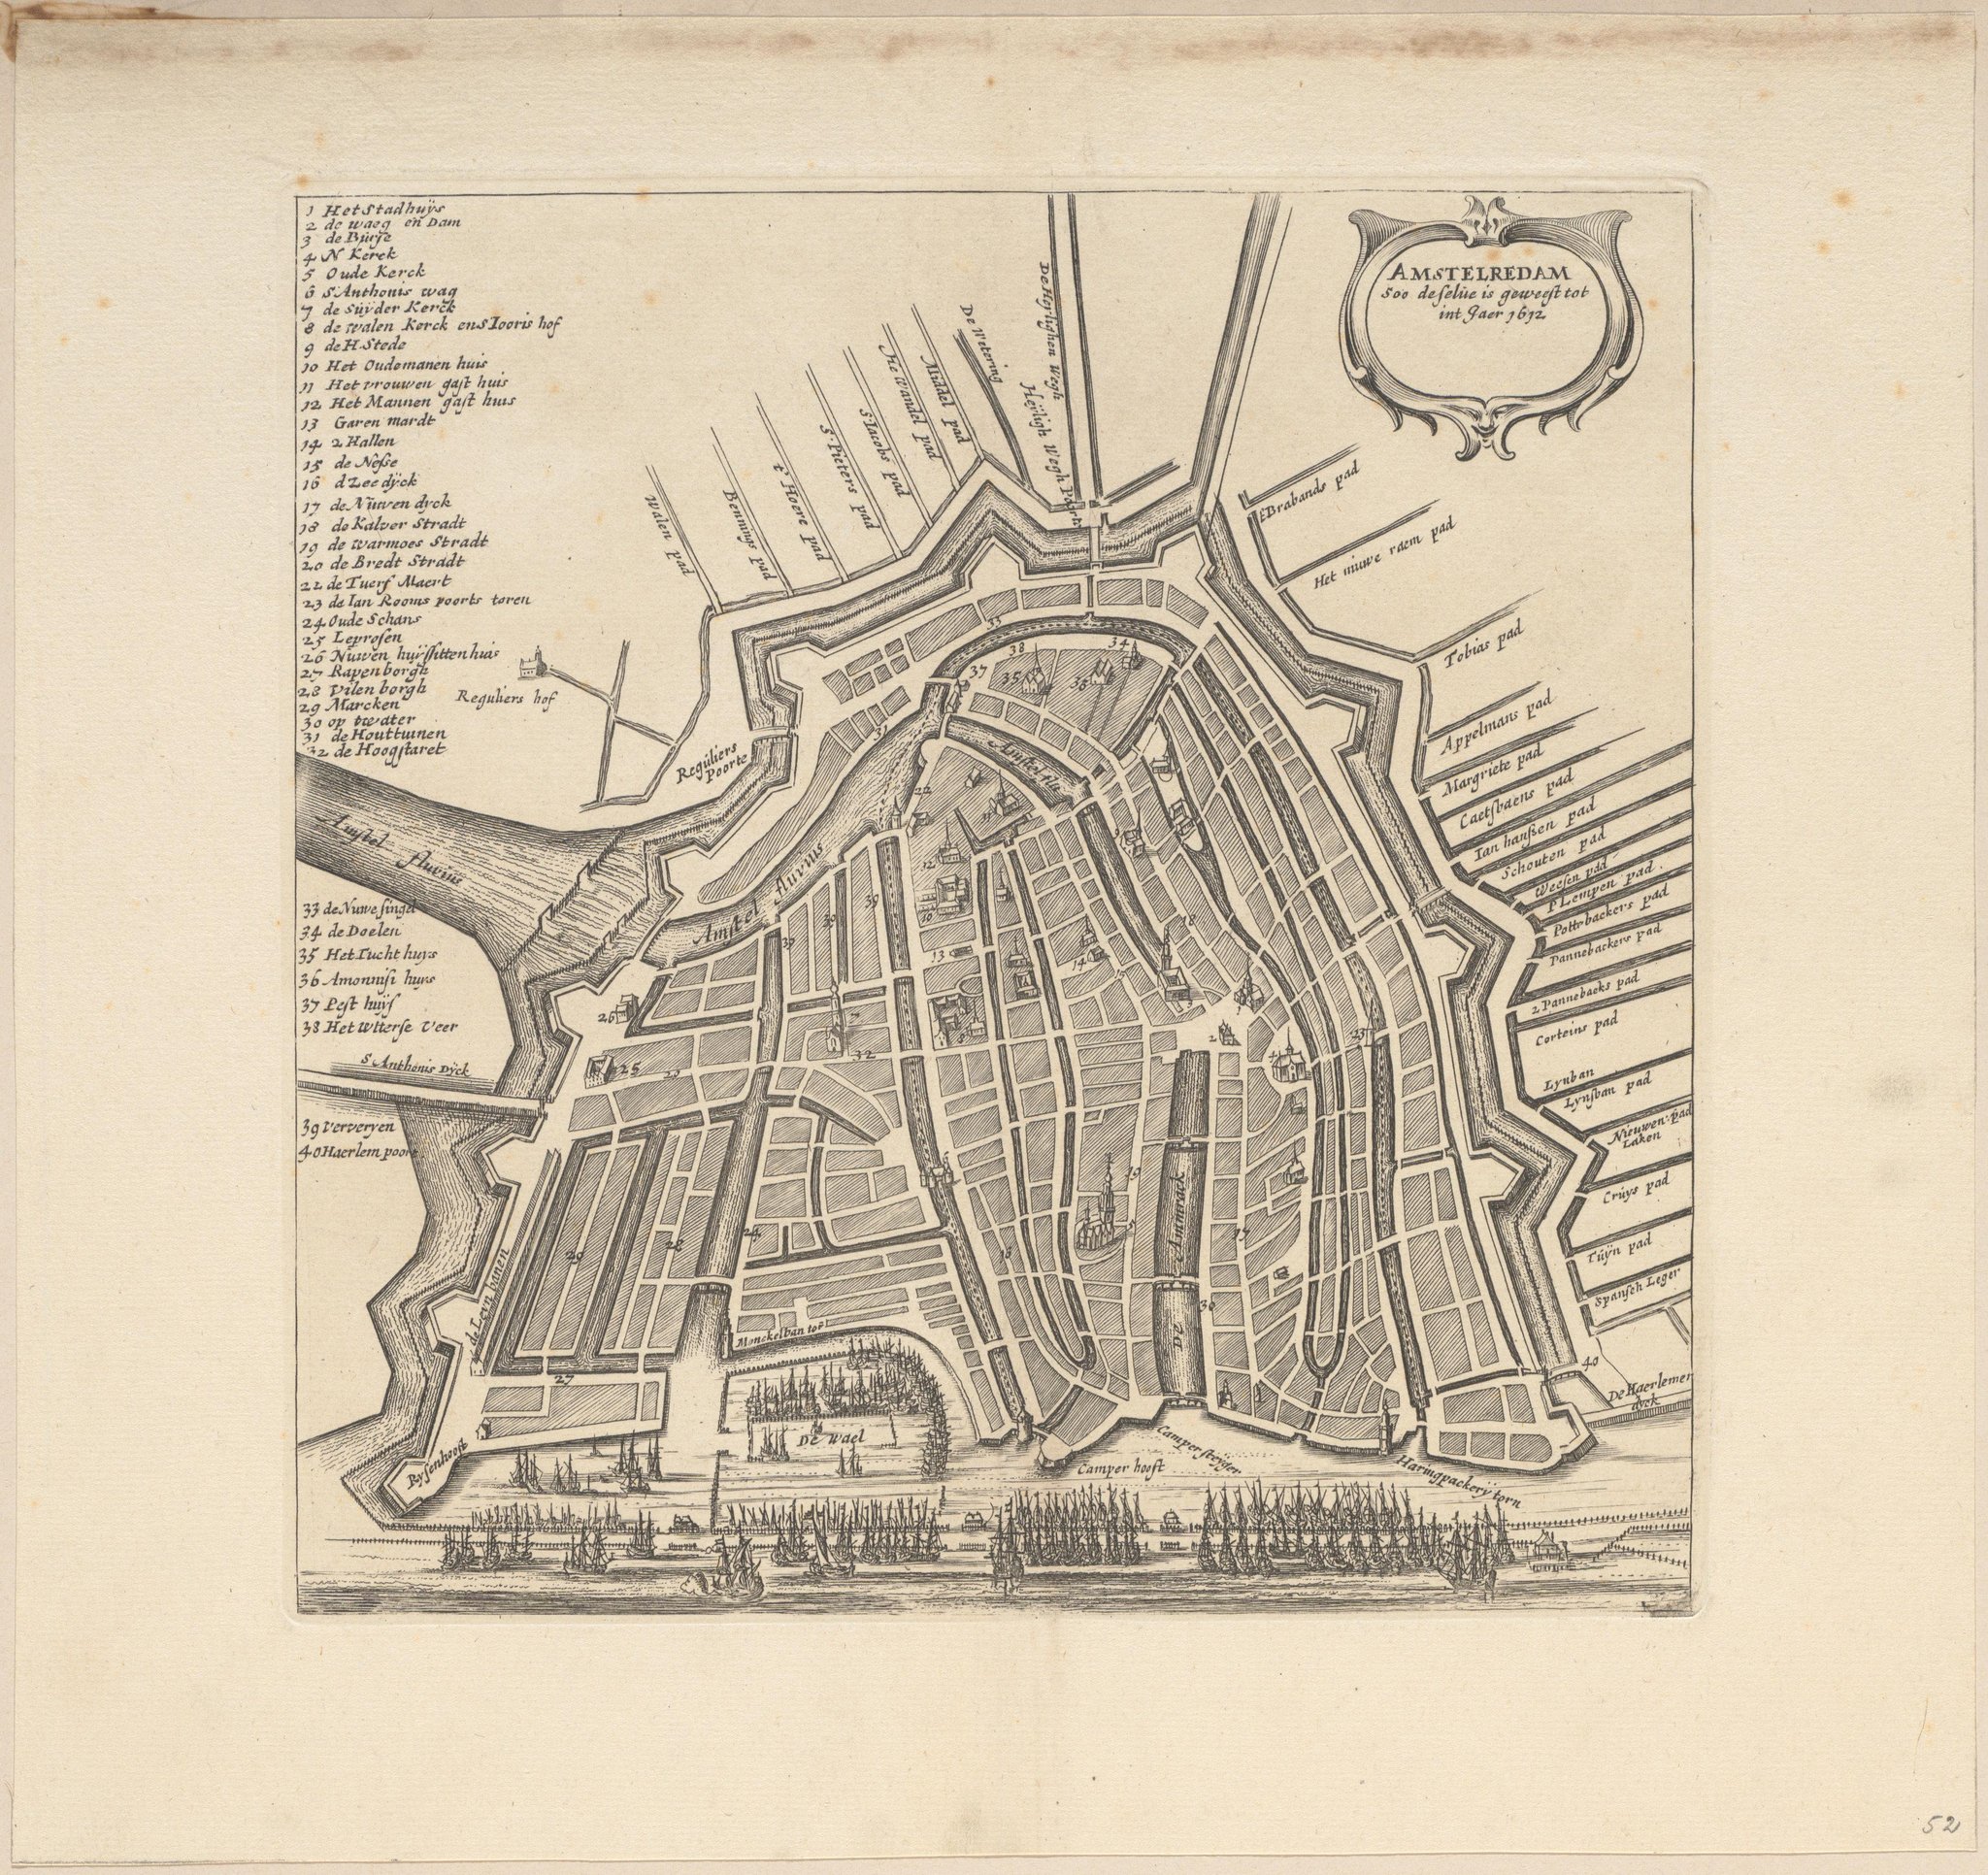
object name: map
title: Amstelredam Soo deselve is geweest tot int Jaer 1612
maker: Anonymous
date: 1663-1748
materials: paper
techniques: engraving, etching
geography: northern netherlands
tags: maps of cities, amsterdam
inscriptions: collector's mark: Lugt 1641b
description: Prent gebruikt in: Handvesten, privilegien, octroyen, costumen en willekeuren der stad Amstelredam. Amsterdam: Otto Barentsz. Smient en Jodocus Smient, 1662 [i.e. 1663]. En in: Vervolg van de handvesten, privilegien, octroyen, costumen en willekeuren der stad Amstelredam (...). Amsterdam: Otto Barentsz. Smient en Bernardus Otto Smient, 1683. En in: Hand-vesten, privilegien, octroyen, costumen en willekeuren der stad Amstelredam. Amsterdam: Jan Rieuwertsz. II, 1694. En in: Handvesten, ofte privilegien ende octroyen, mitsgaders willekeuren, costuimen, ordonnantien en handelingen der stad Amstelredam (…). Amsterdam: Hendrik Janssonius van Waesberge, Petrus Schouten en Salomon Schouten, 1748.